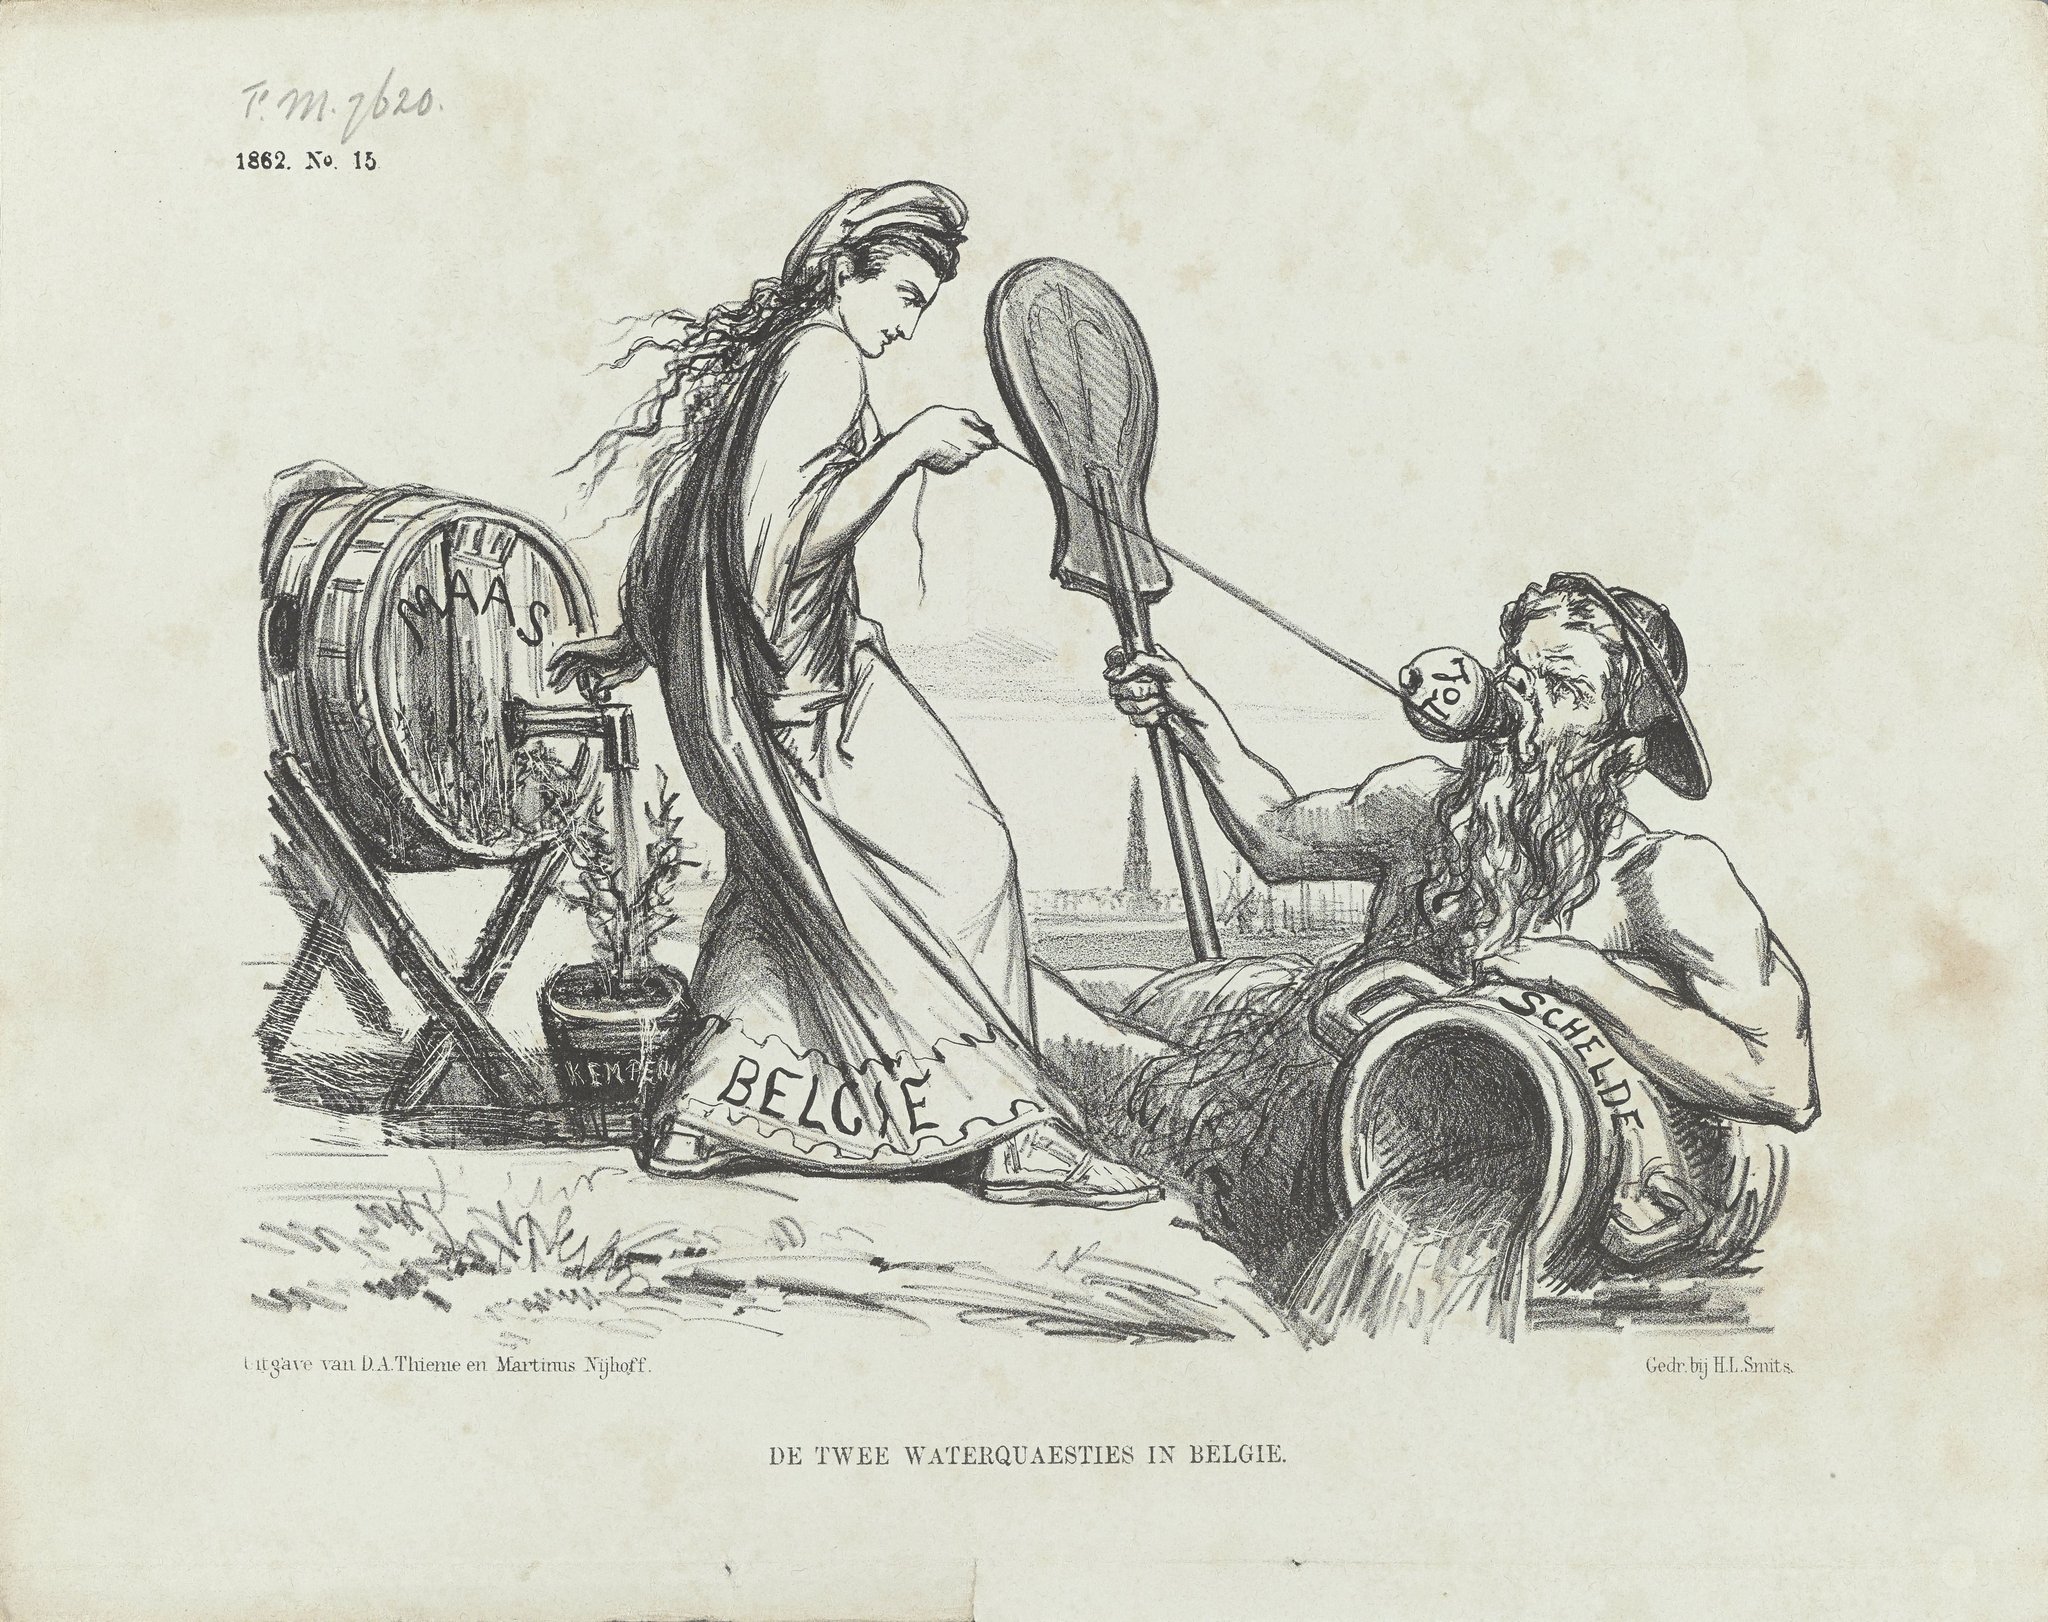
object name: print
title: Spotprent op waterkwesties in België, 1862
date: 1862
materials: paper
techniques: lithograph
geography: the hague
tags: personifications of countries, nations, states, districts, etc., river-gods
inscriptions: collector's mark: Lugt 2228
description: Spotprent op waterkwesties in België. De Belgische Maagd tracht de tol uit de mond van de riviergod van de Schelde te trekken en tapt tegelijkertijd water uit het vat van de Maas. Plaat verschenen bij het weekblad De Nederlandsche Spectator, nr. 15, 12 april 1862.